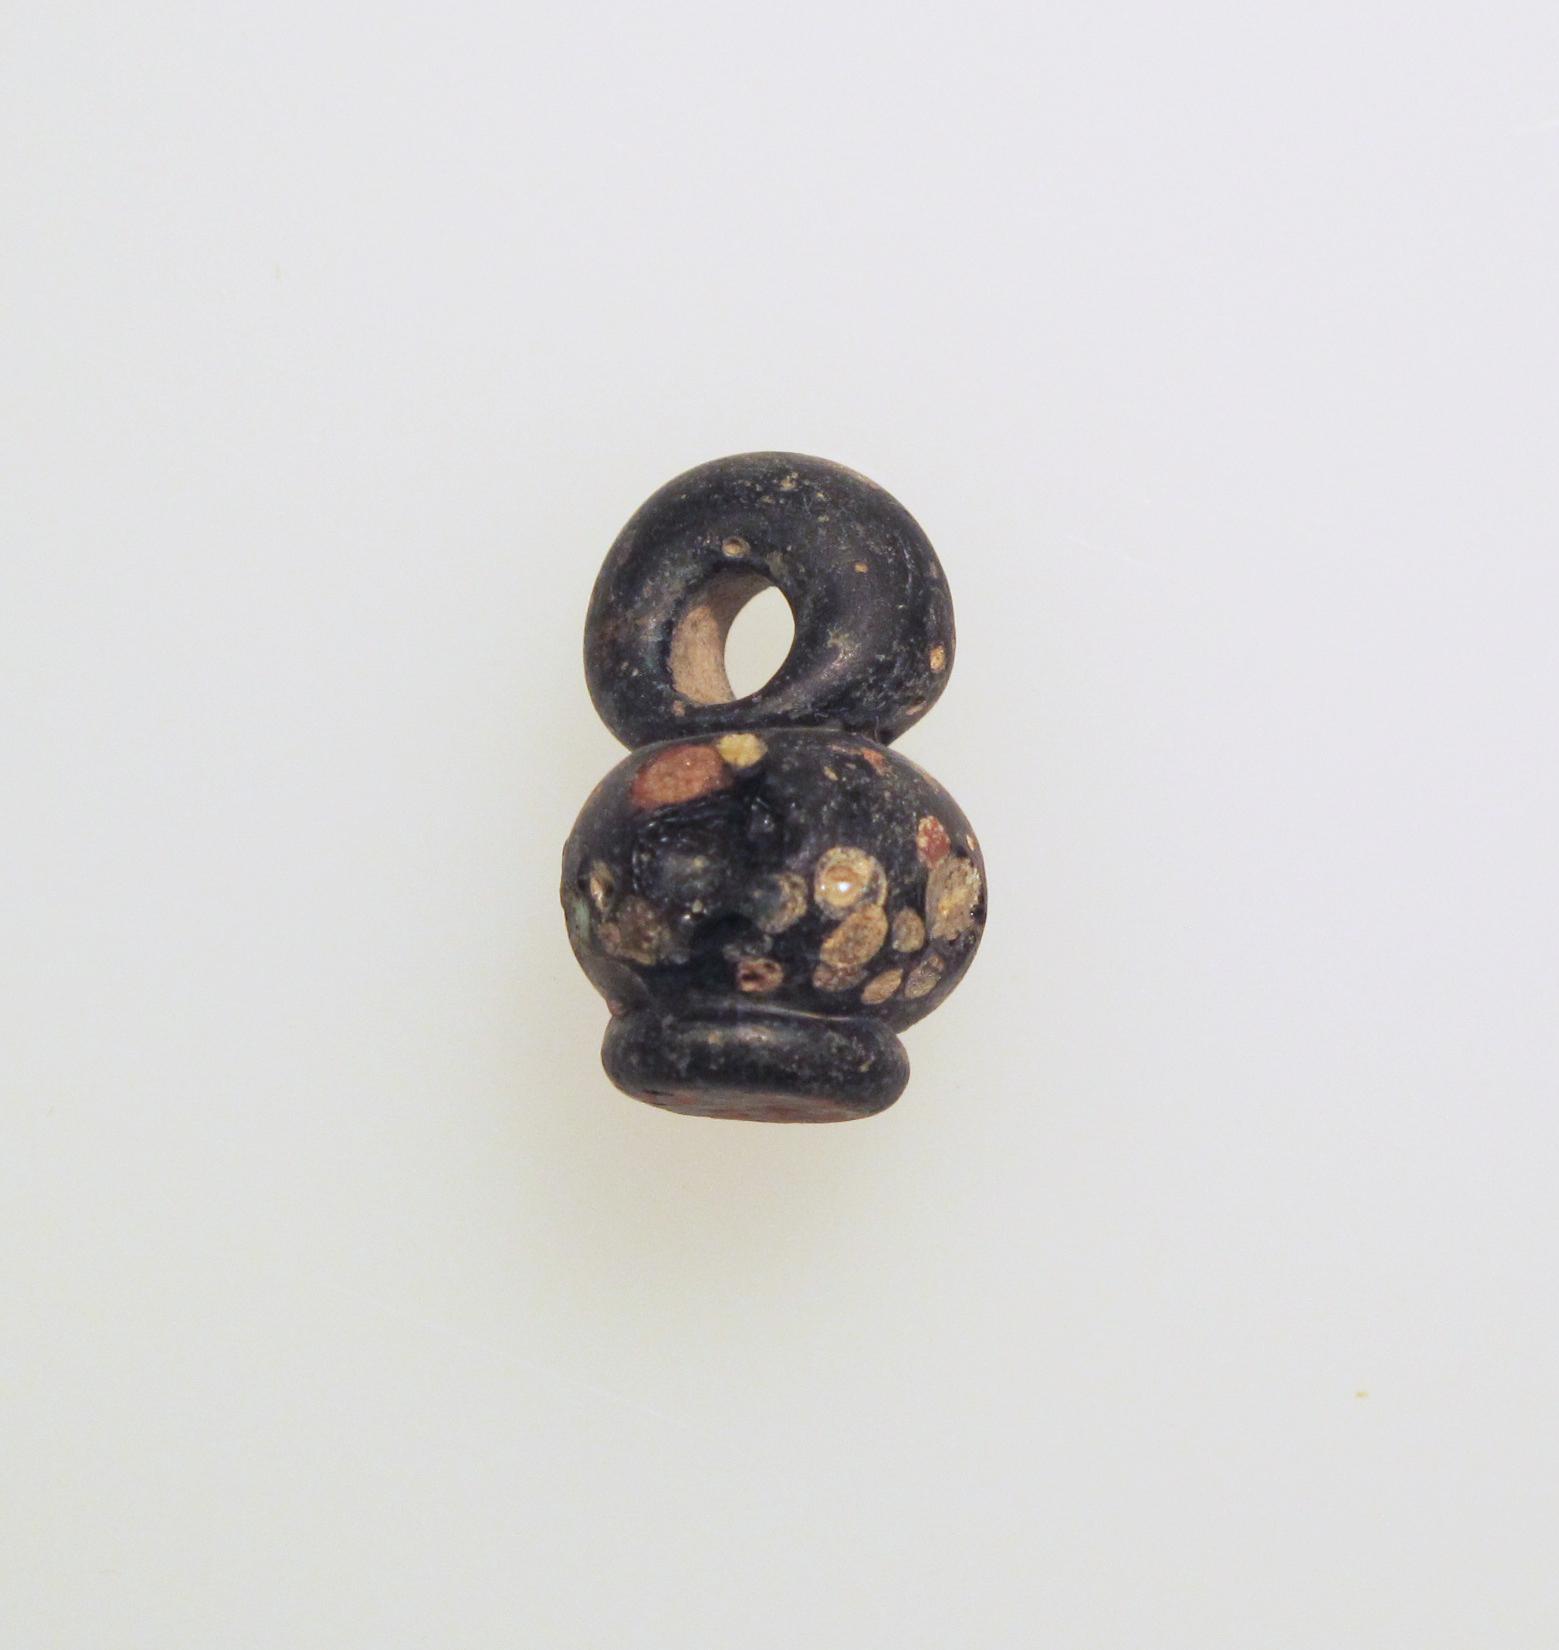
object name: pendant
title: Glass pendant in the form of a jar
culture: roman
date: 201-400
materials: glass